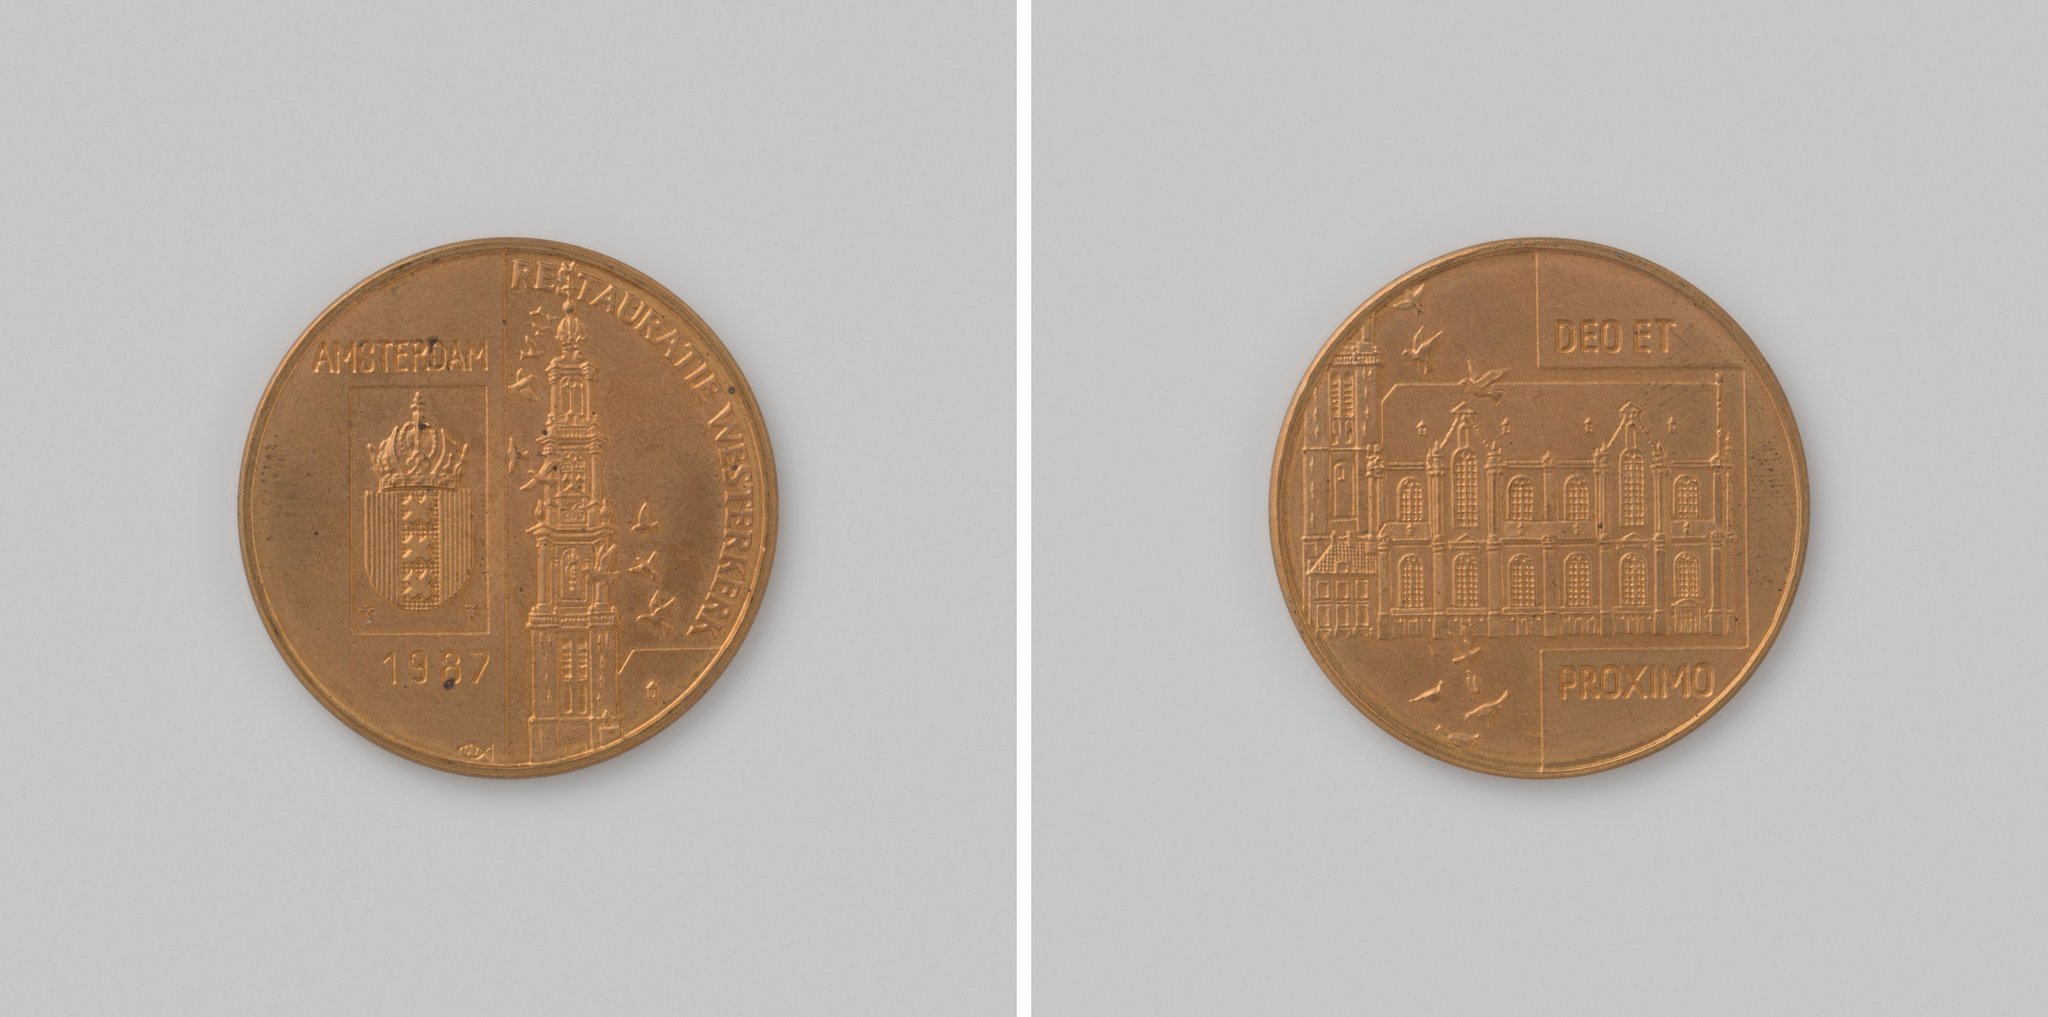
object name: history medal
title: Restauratie van de Westerkerk te Amsterdam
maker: willem vis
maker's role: sculptor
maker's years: 1936-2007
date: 1987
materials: metal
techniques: gilding, striking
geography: utrecht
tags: westerkerk